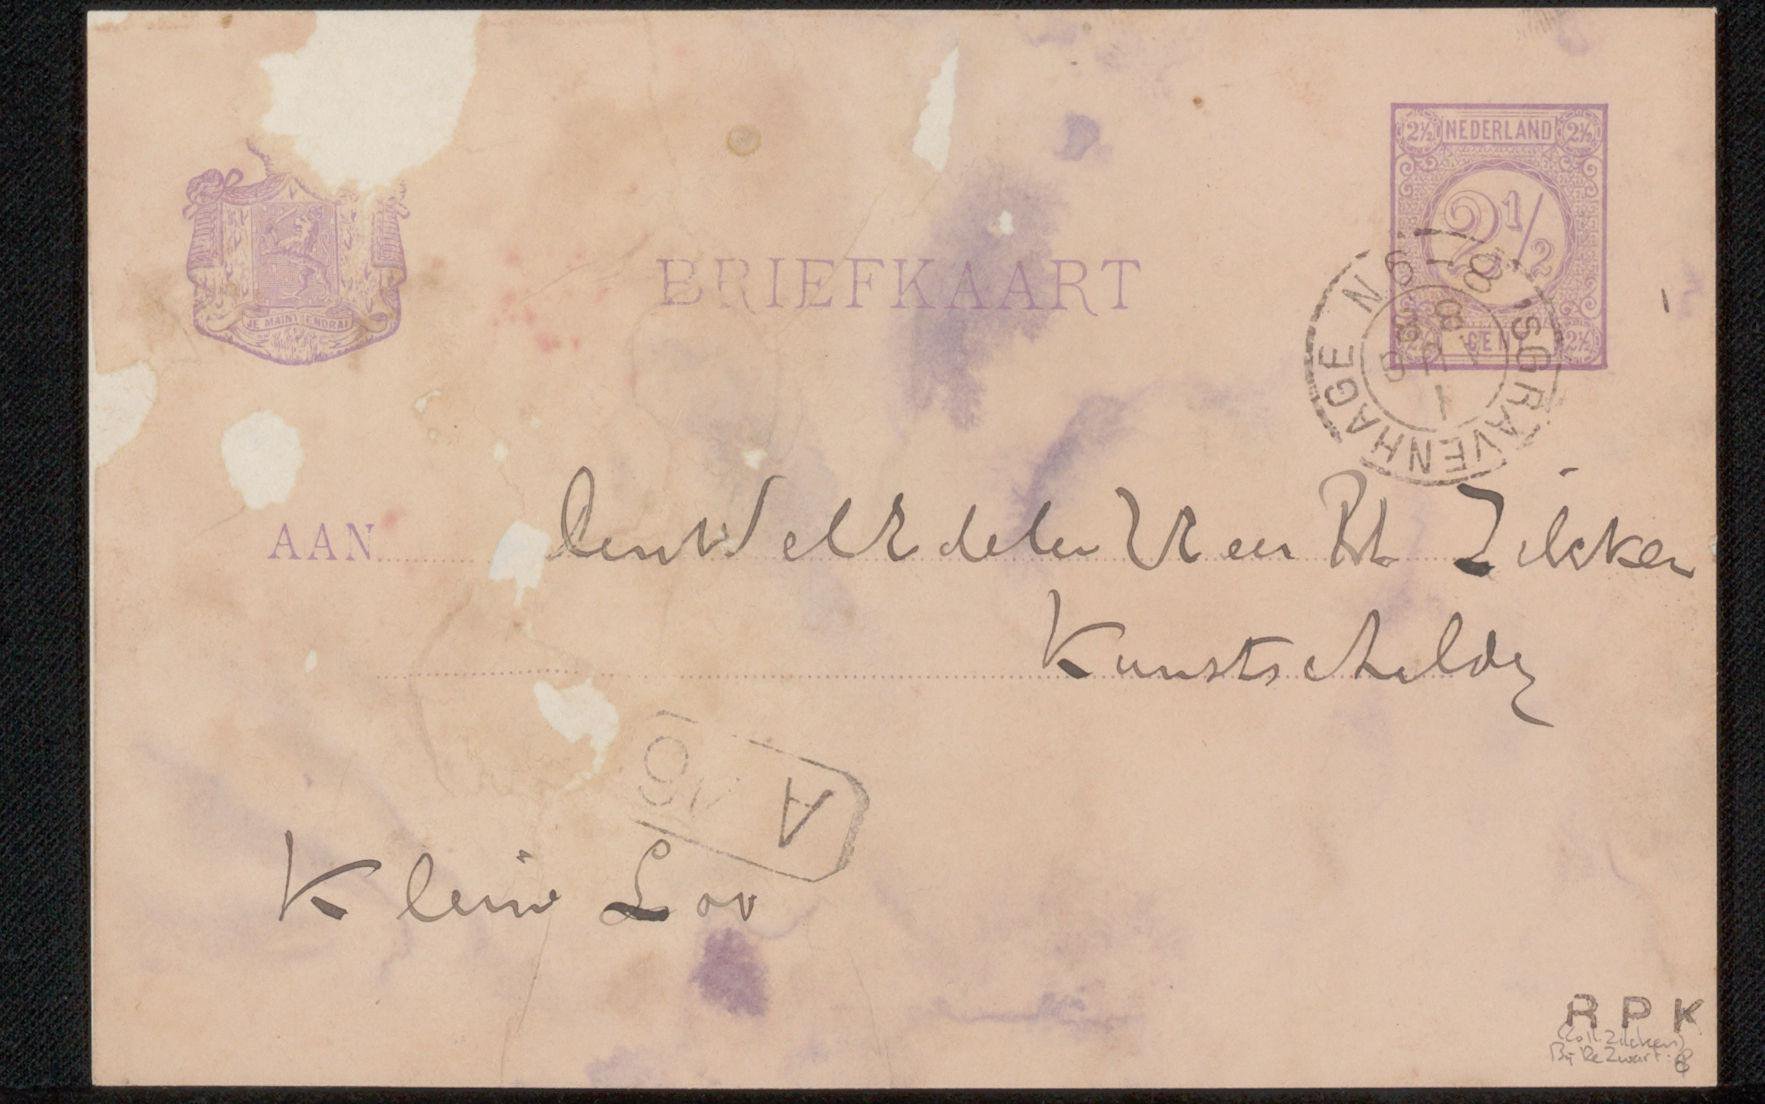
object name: postcard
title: Briefkaart aan Philip Zilcken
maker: willem de zwart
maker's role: draughtsman, painter, print maker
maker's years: 1862-1931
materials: cardboard, ink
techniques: pen, writing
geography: the hague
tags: philip zilcken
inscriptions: collector's mark: ‘RPK’